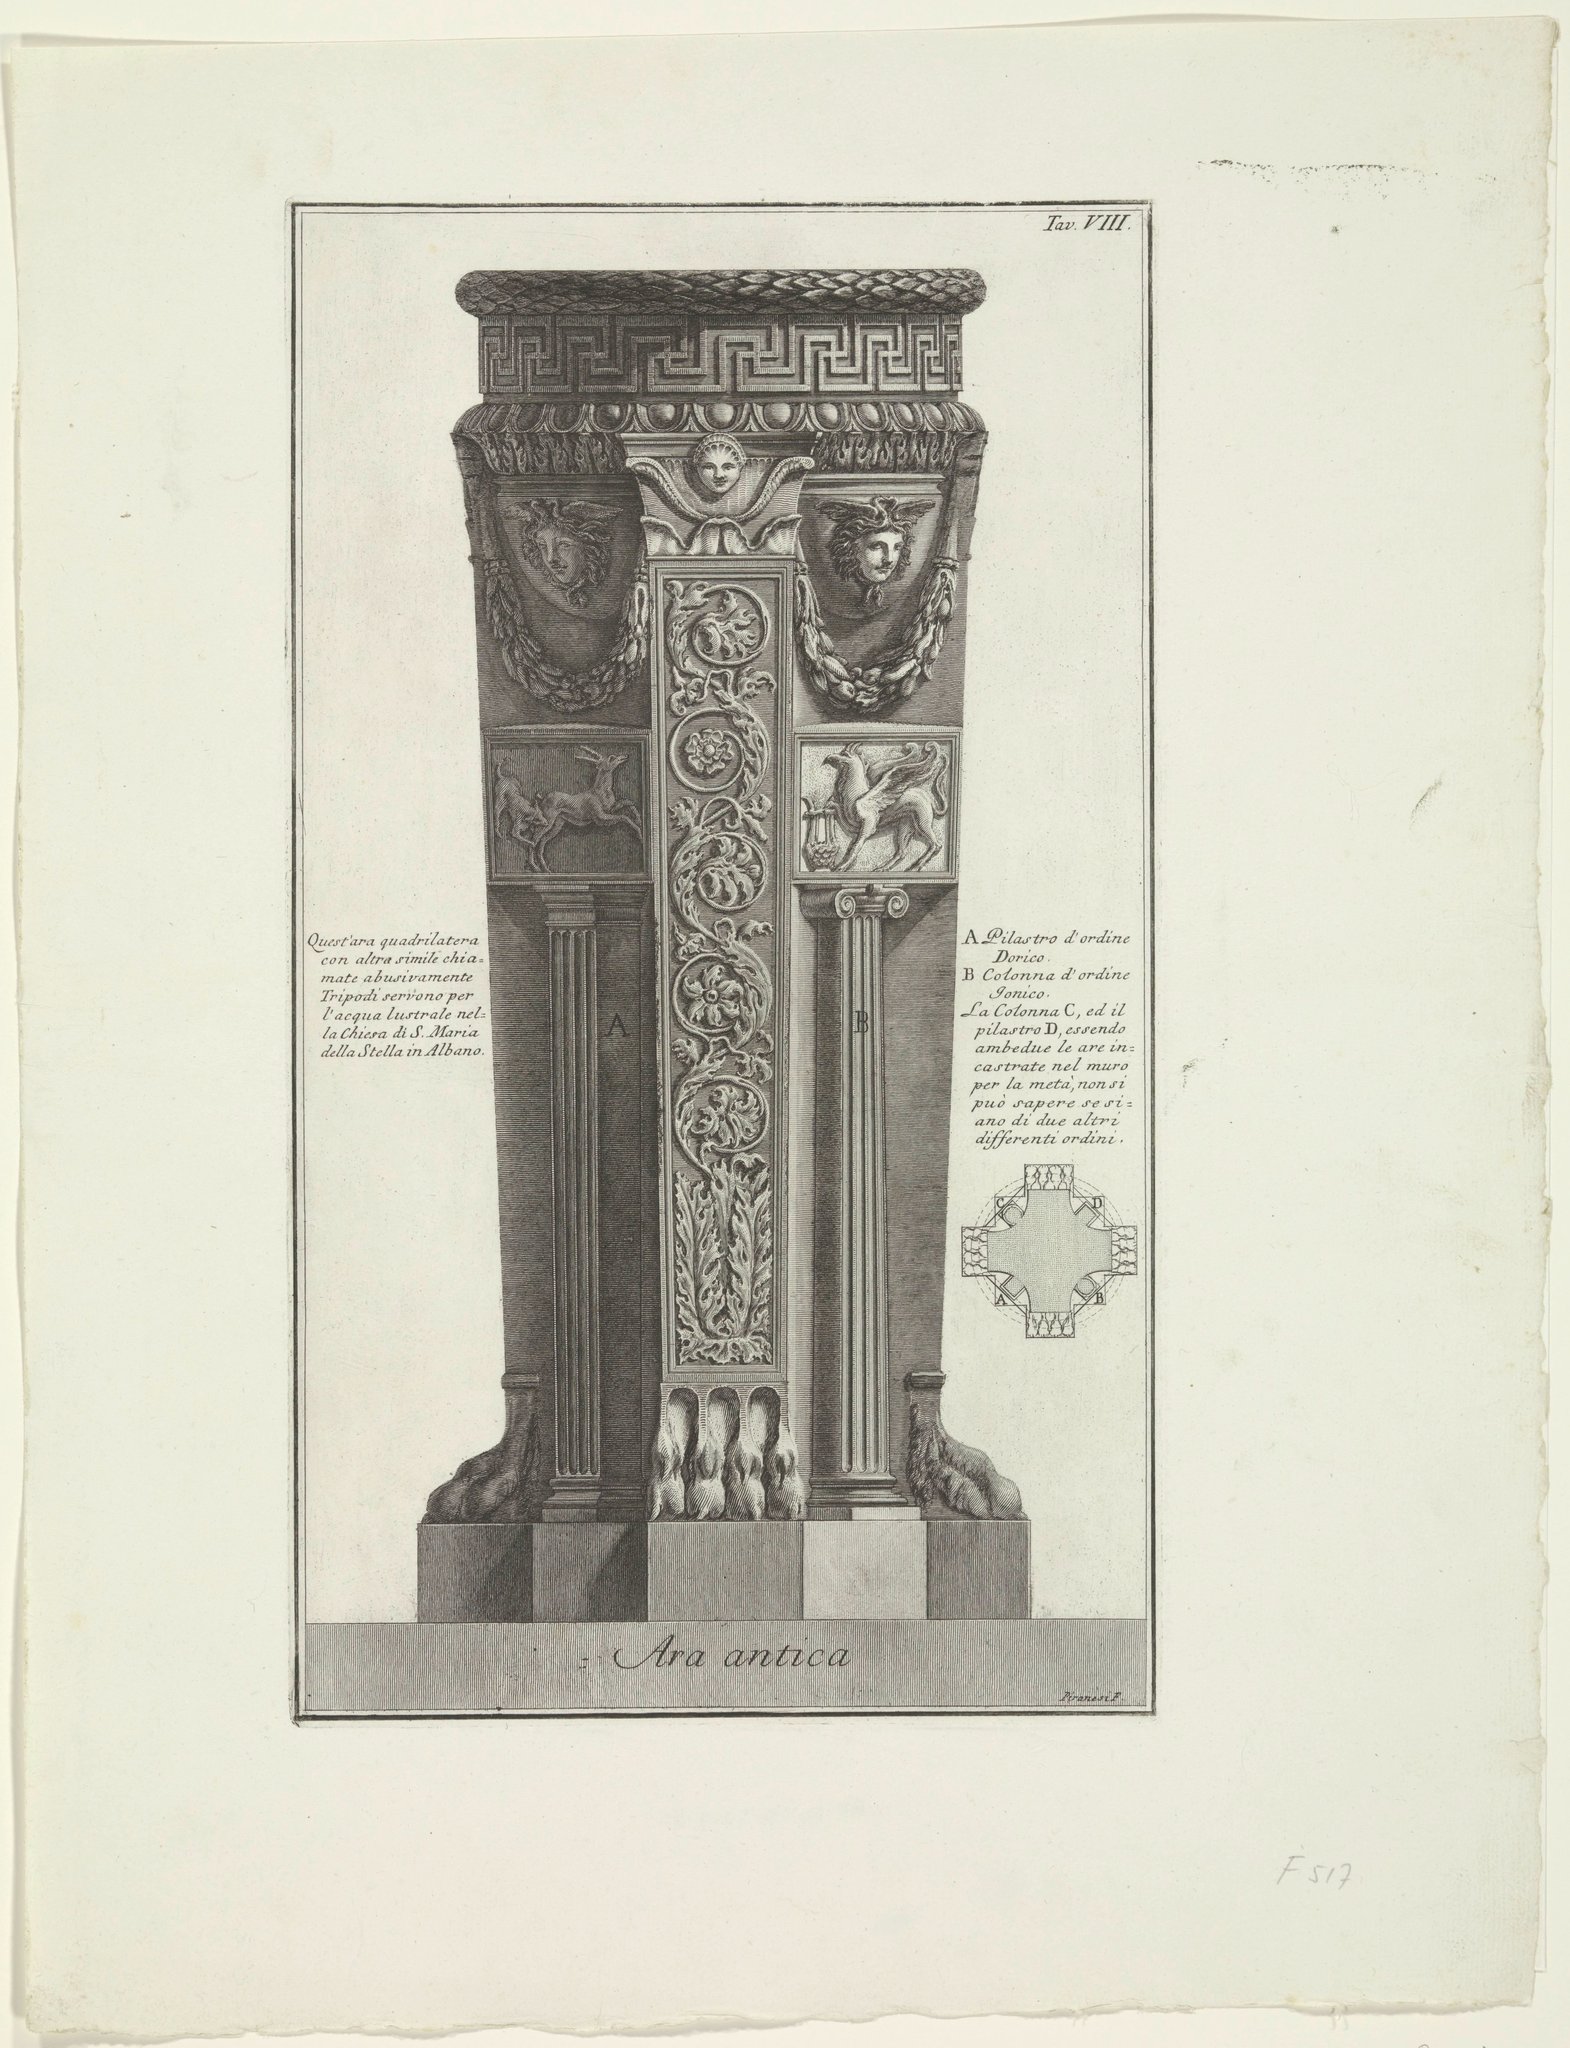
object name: print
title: Vierhoekig vont in de Santa Maria della Stella te Albano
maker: giovanni battista piranesi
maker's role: designer, draughtsman, print maker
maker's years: 1720-1778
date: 1762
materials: paper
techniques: etching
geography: rome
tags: ruin of a building ~ architecture, holy water font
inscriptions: collector's mark: Lugt 2228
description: Een geornamenteerd vierhoekig vont voor heilig water in de kerk Santa Maria della Stella te Albano. Rechts een schematisch bovenaanzicht van het vont. Titel in ondermarge. Genummerd rechtsboven: Tav. VIII. Opschrift links en verklarende lijst met letters rechts.